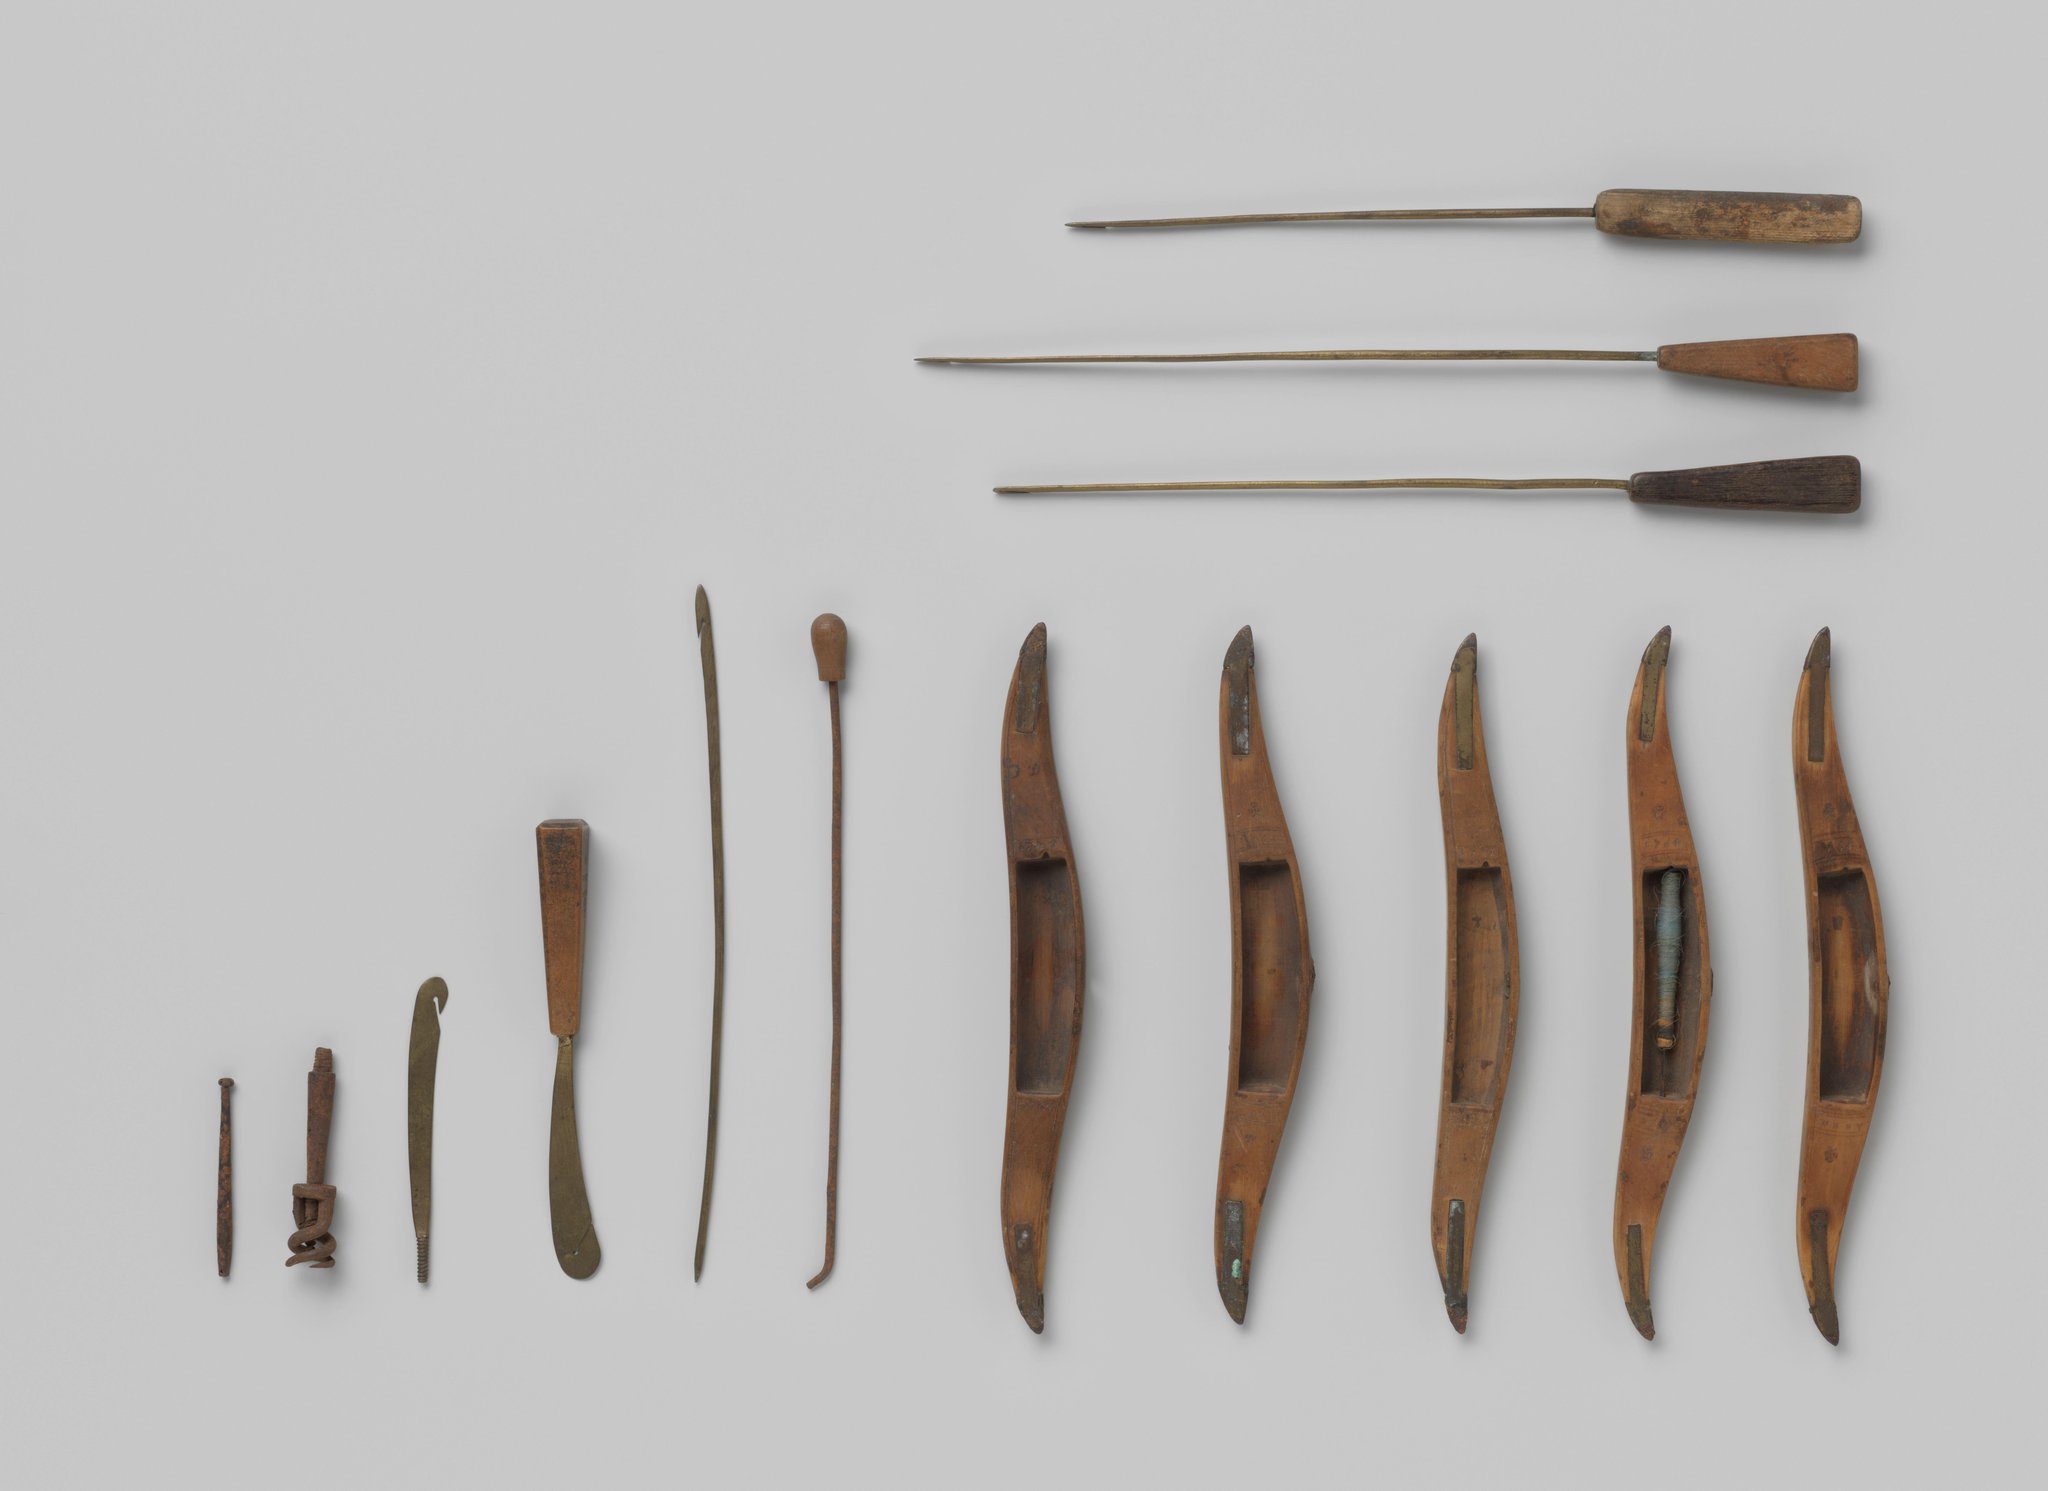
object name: textile working equipment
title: Een verzameling voorwerpen die betrekking heeft op de fluweelindustrie te Naarden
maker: Anonymous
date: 1735-1774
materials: copper, iron, wood, yarns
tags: naarden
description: Een verzameling voorwerpen die betrekking heeft op de fluweelindustrie te Naarden. Onder andere stofscharen, spoelen en fluweelsnijders.